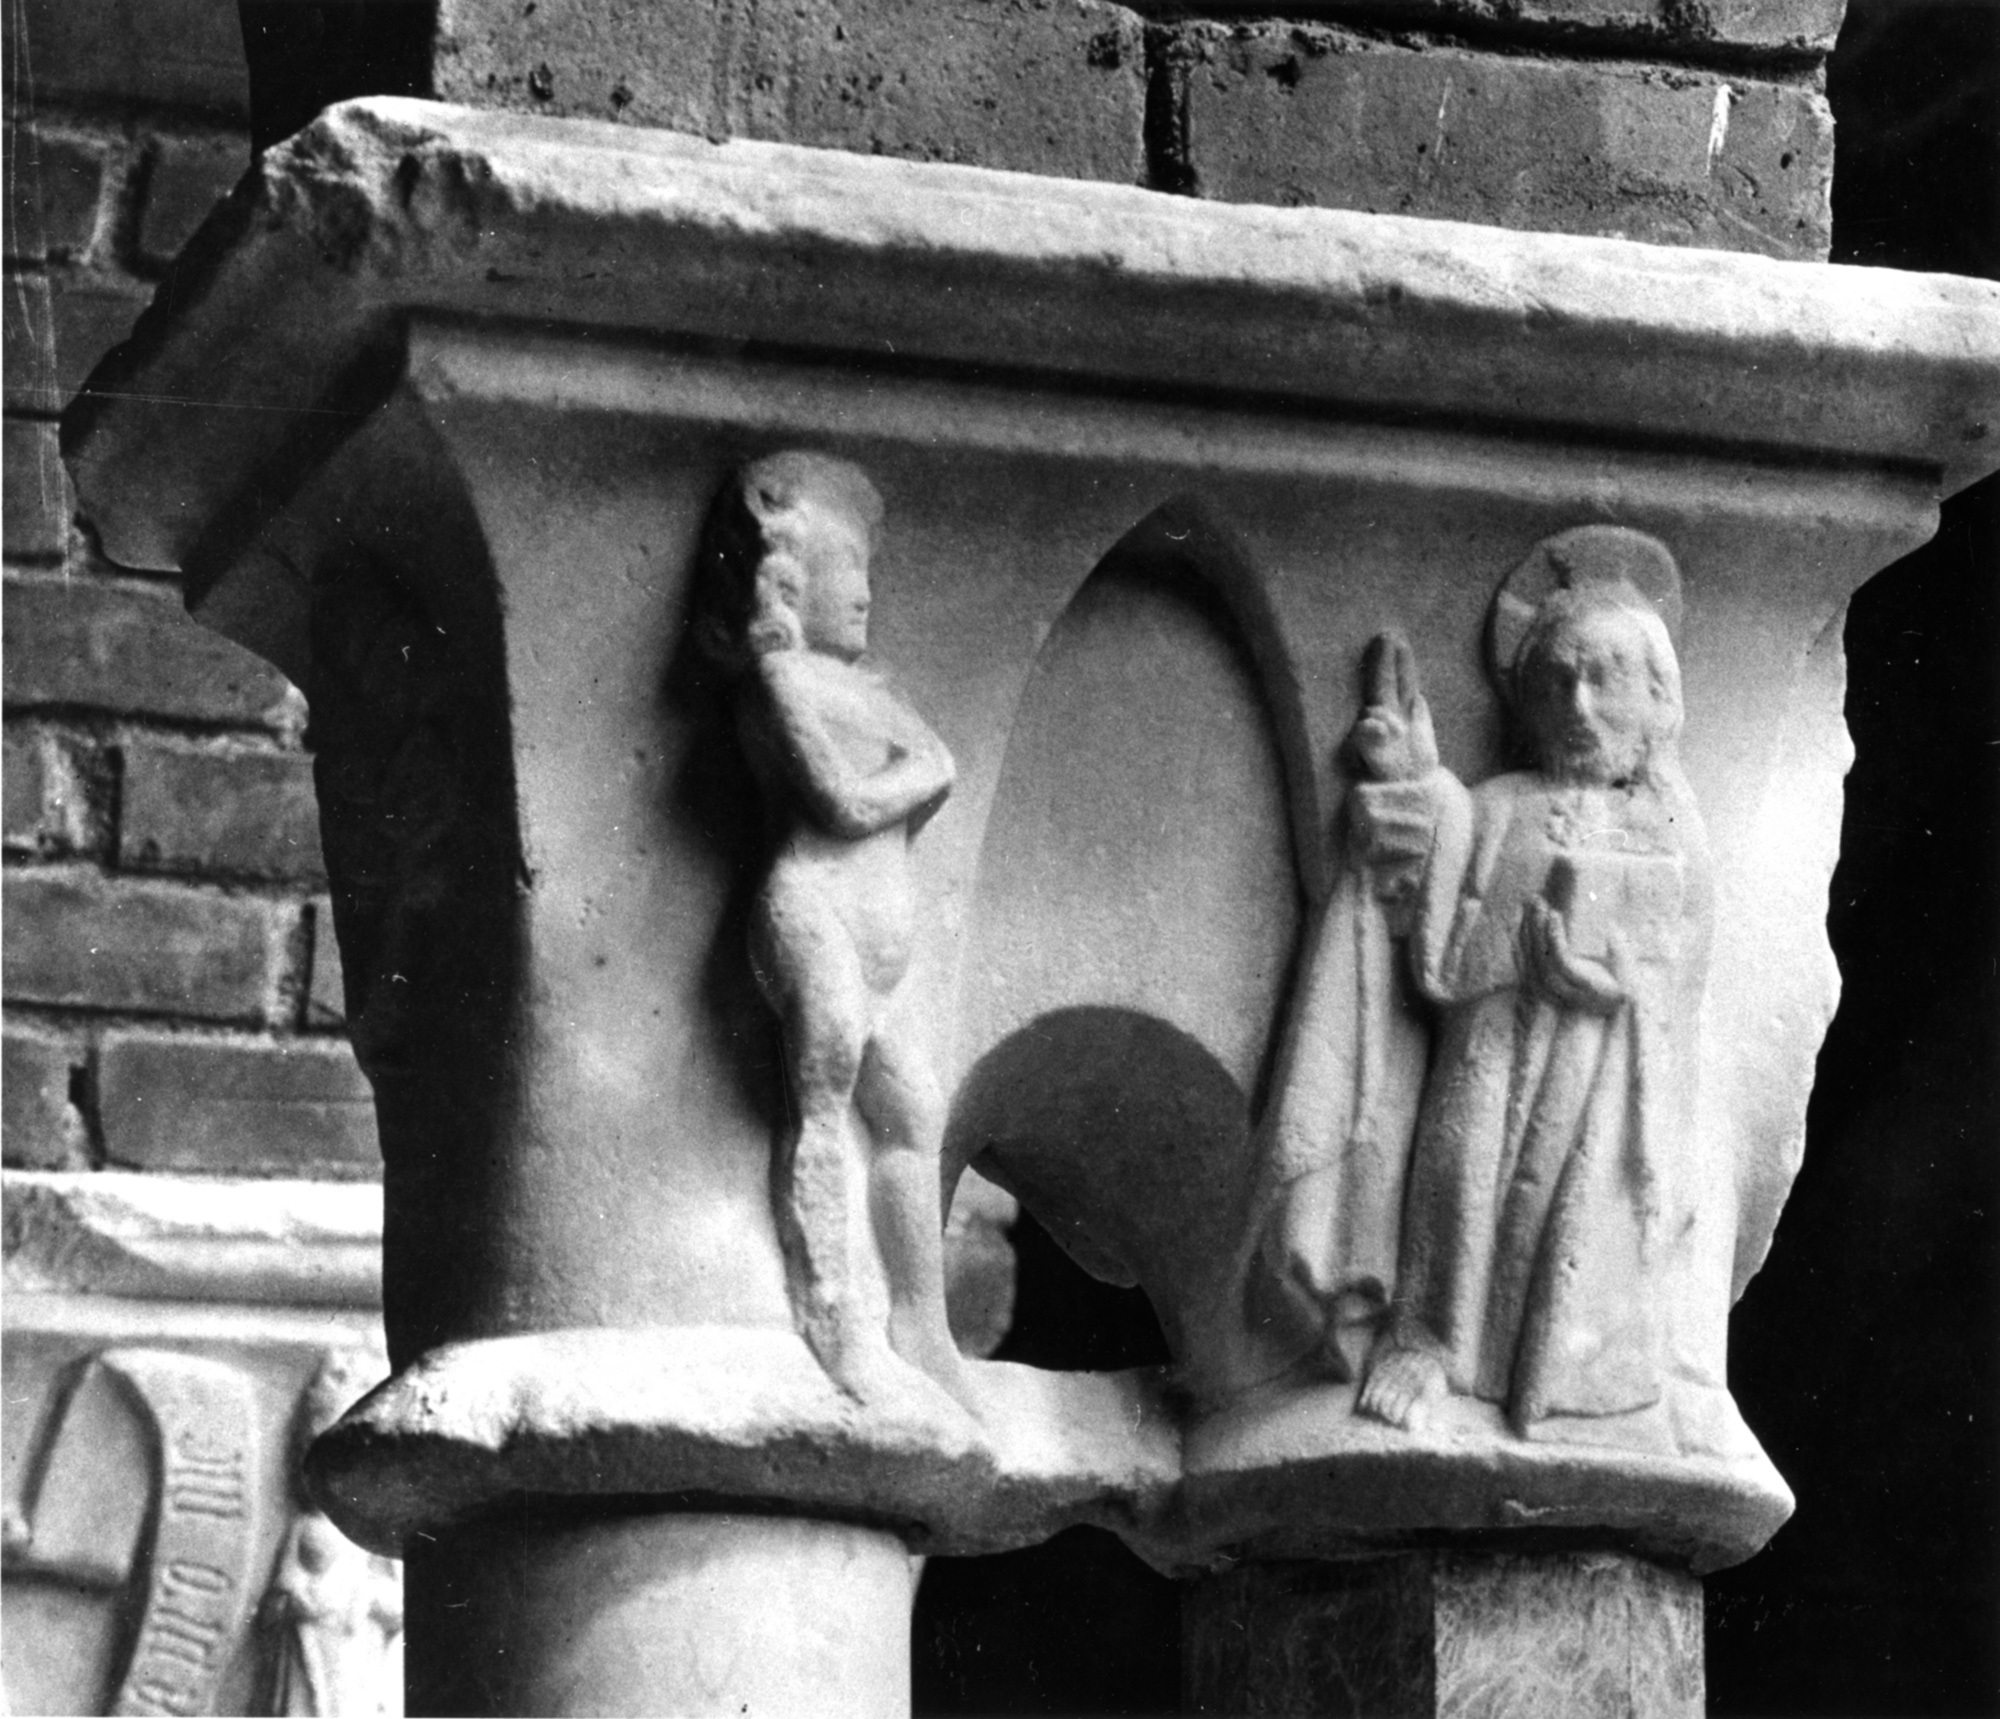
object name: capital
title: Double Capital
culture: french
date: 1467-1500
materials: marble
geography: france